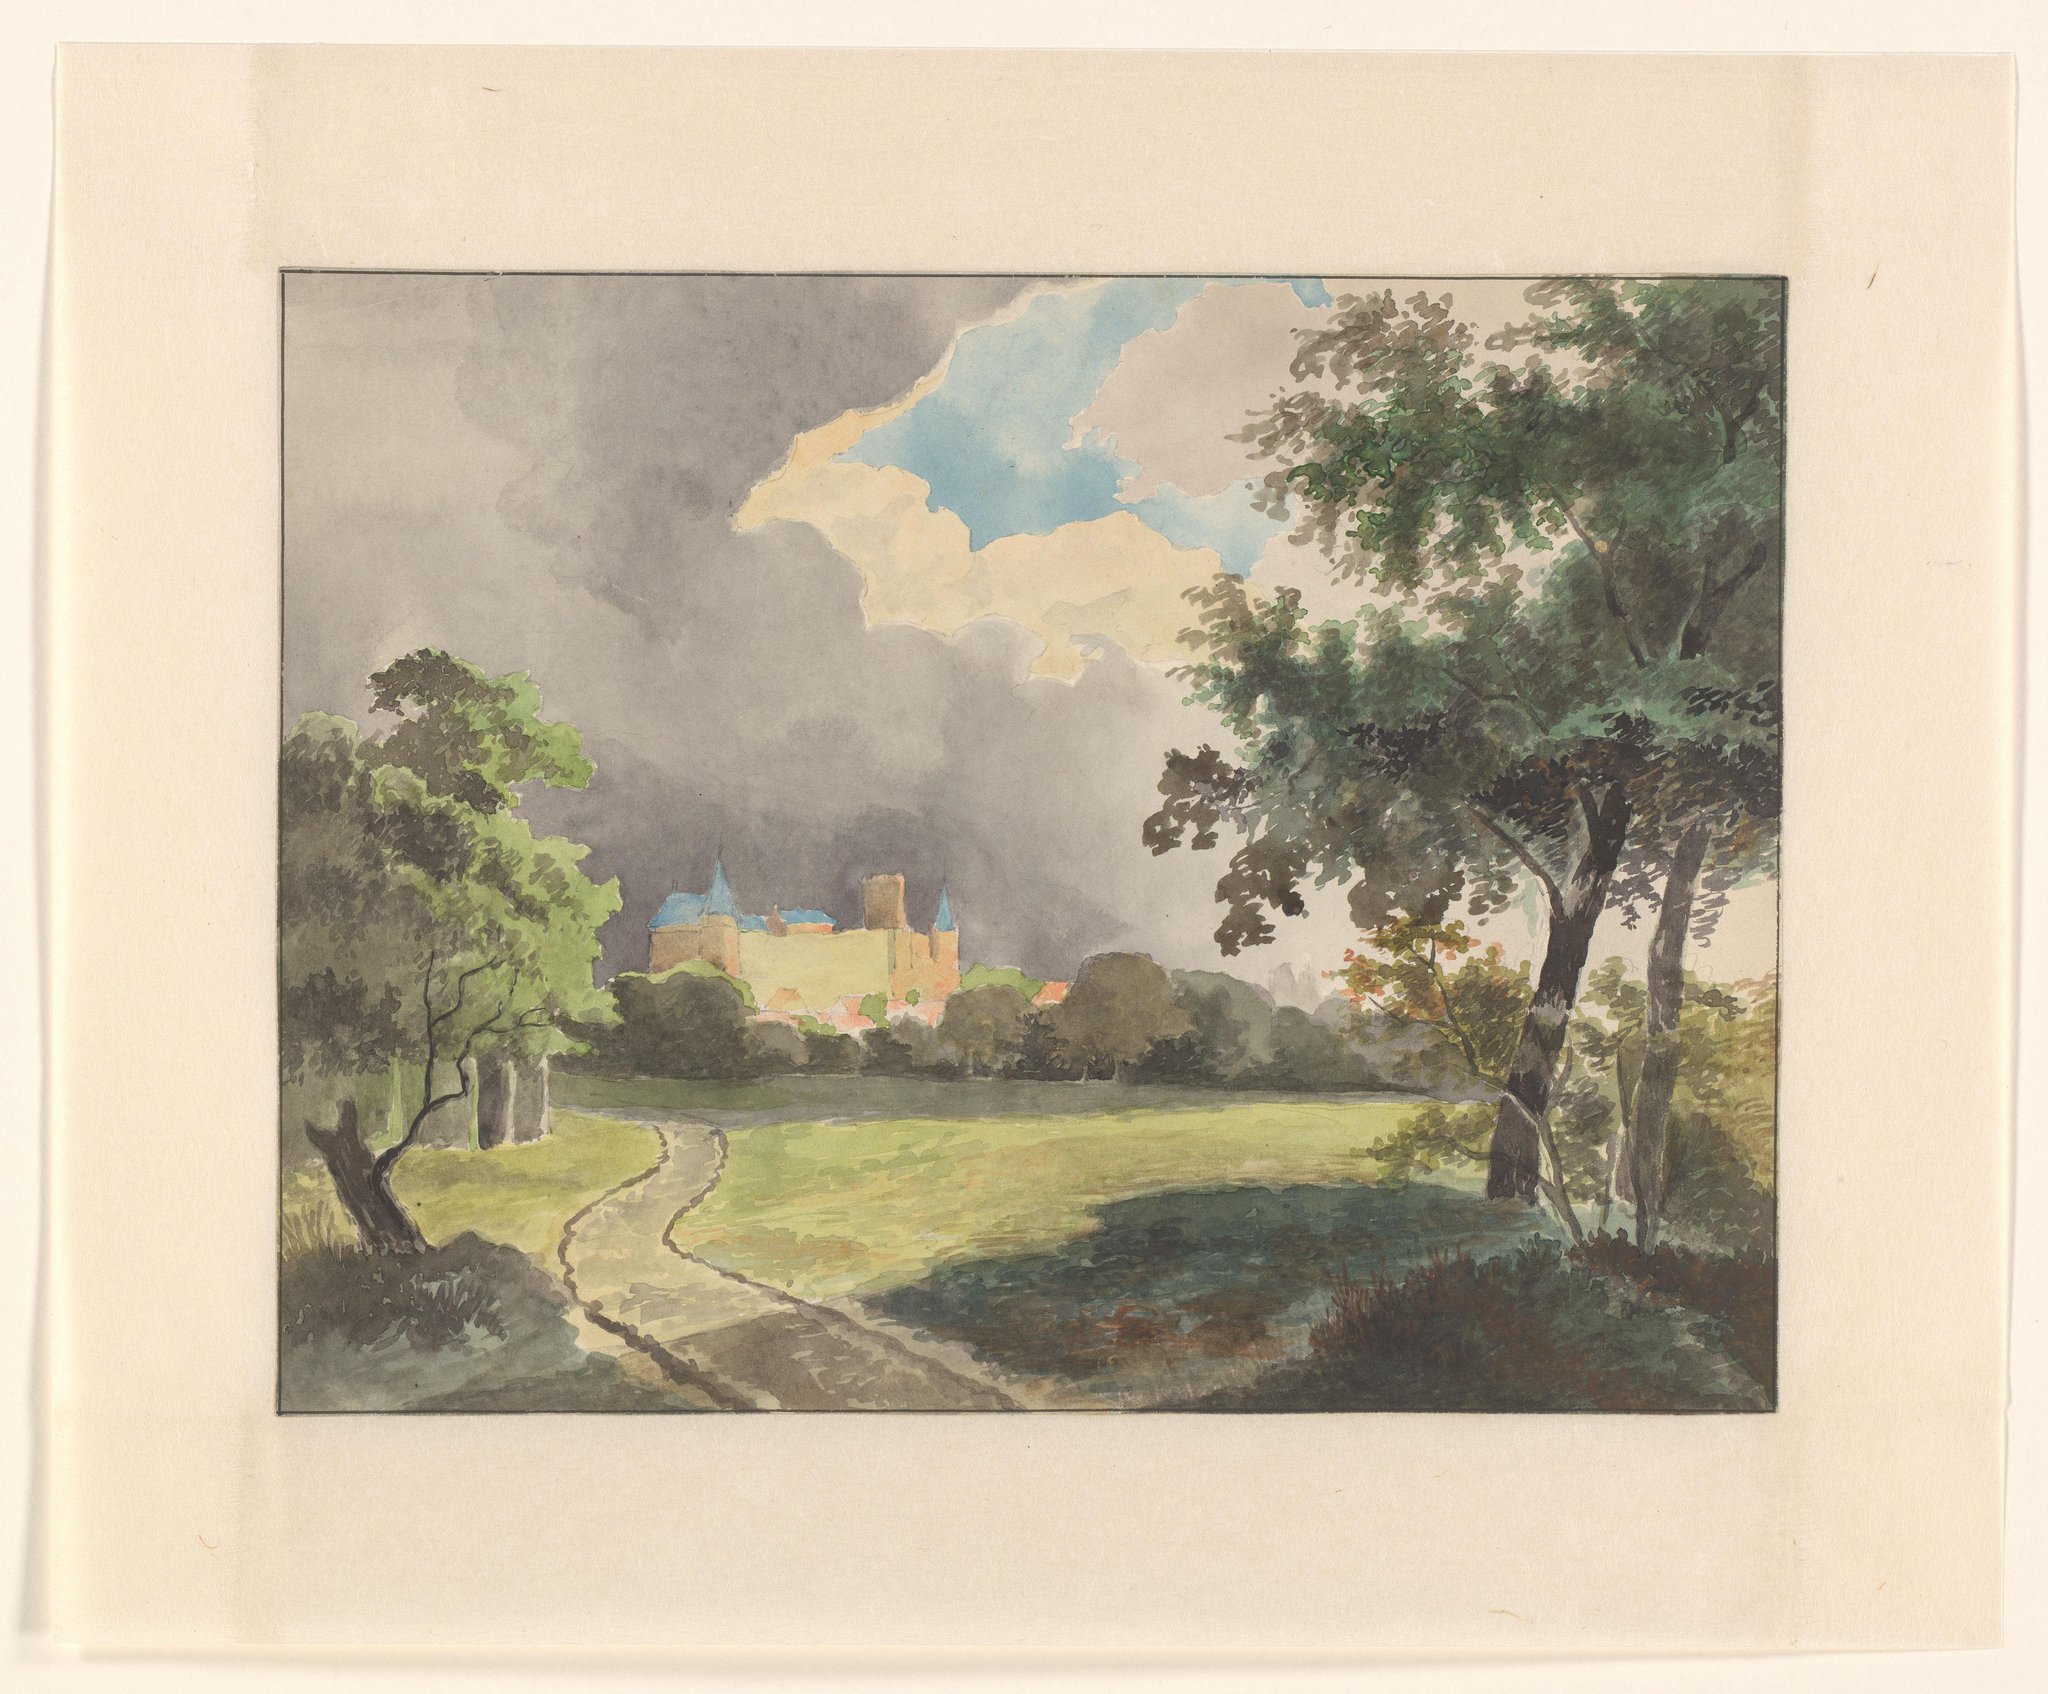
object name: drawing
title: Landschap met kasteel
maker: johannes van reijn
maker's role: draughtsman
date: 1800-1900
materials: paper, pencil, watercolor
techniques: brush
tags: landscapes, castle